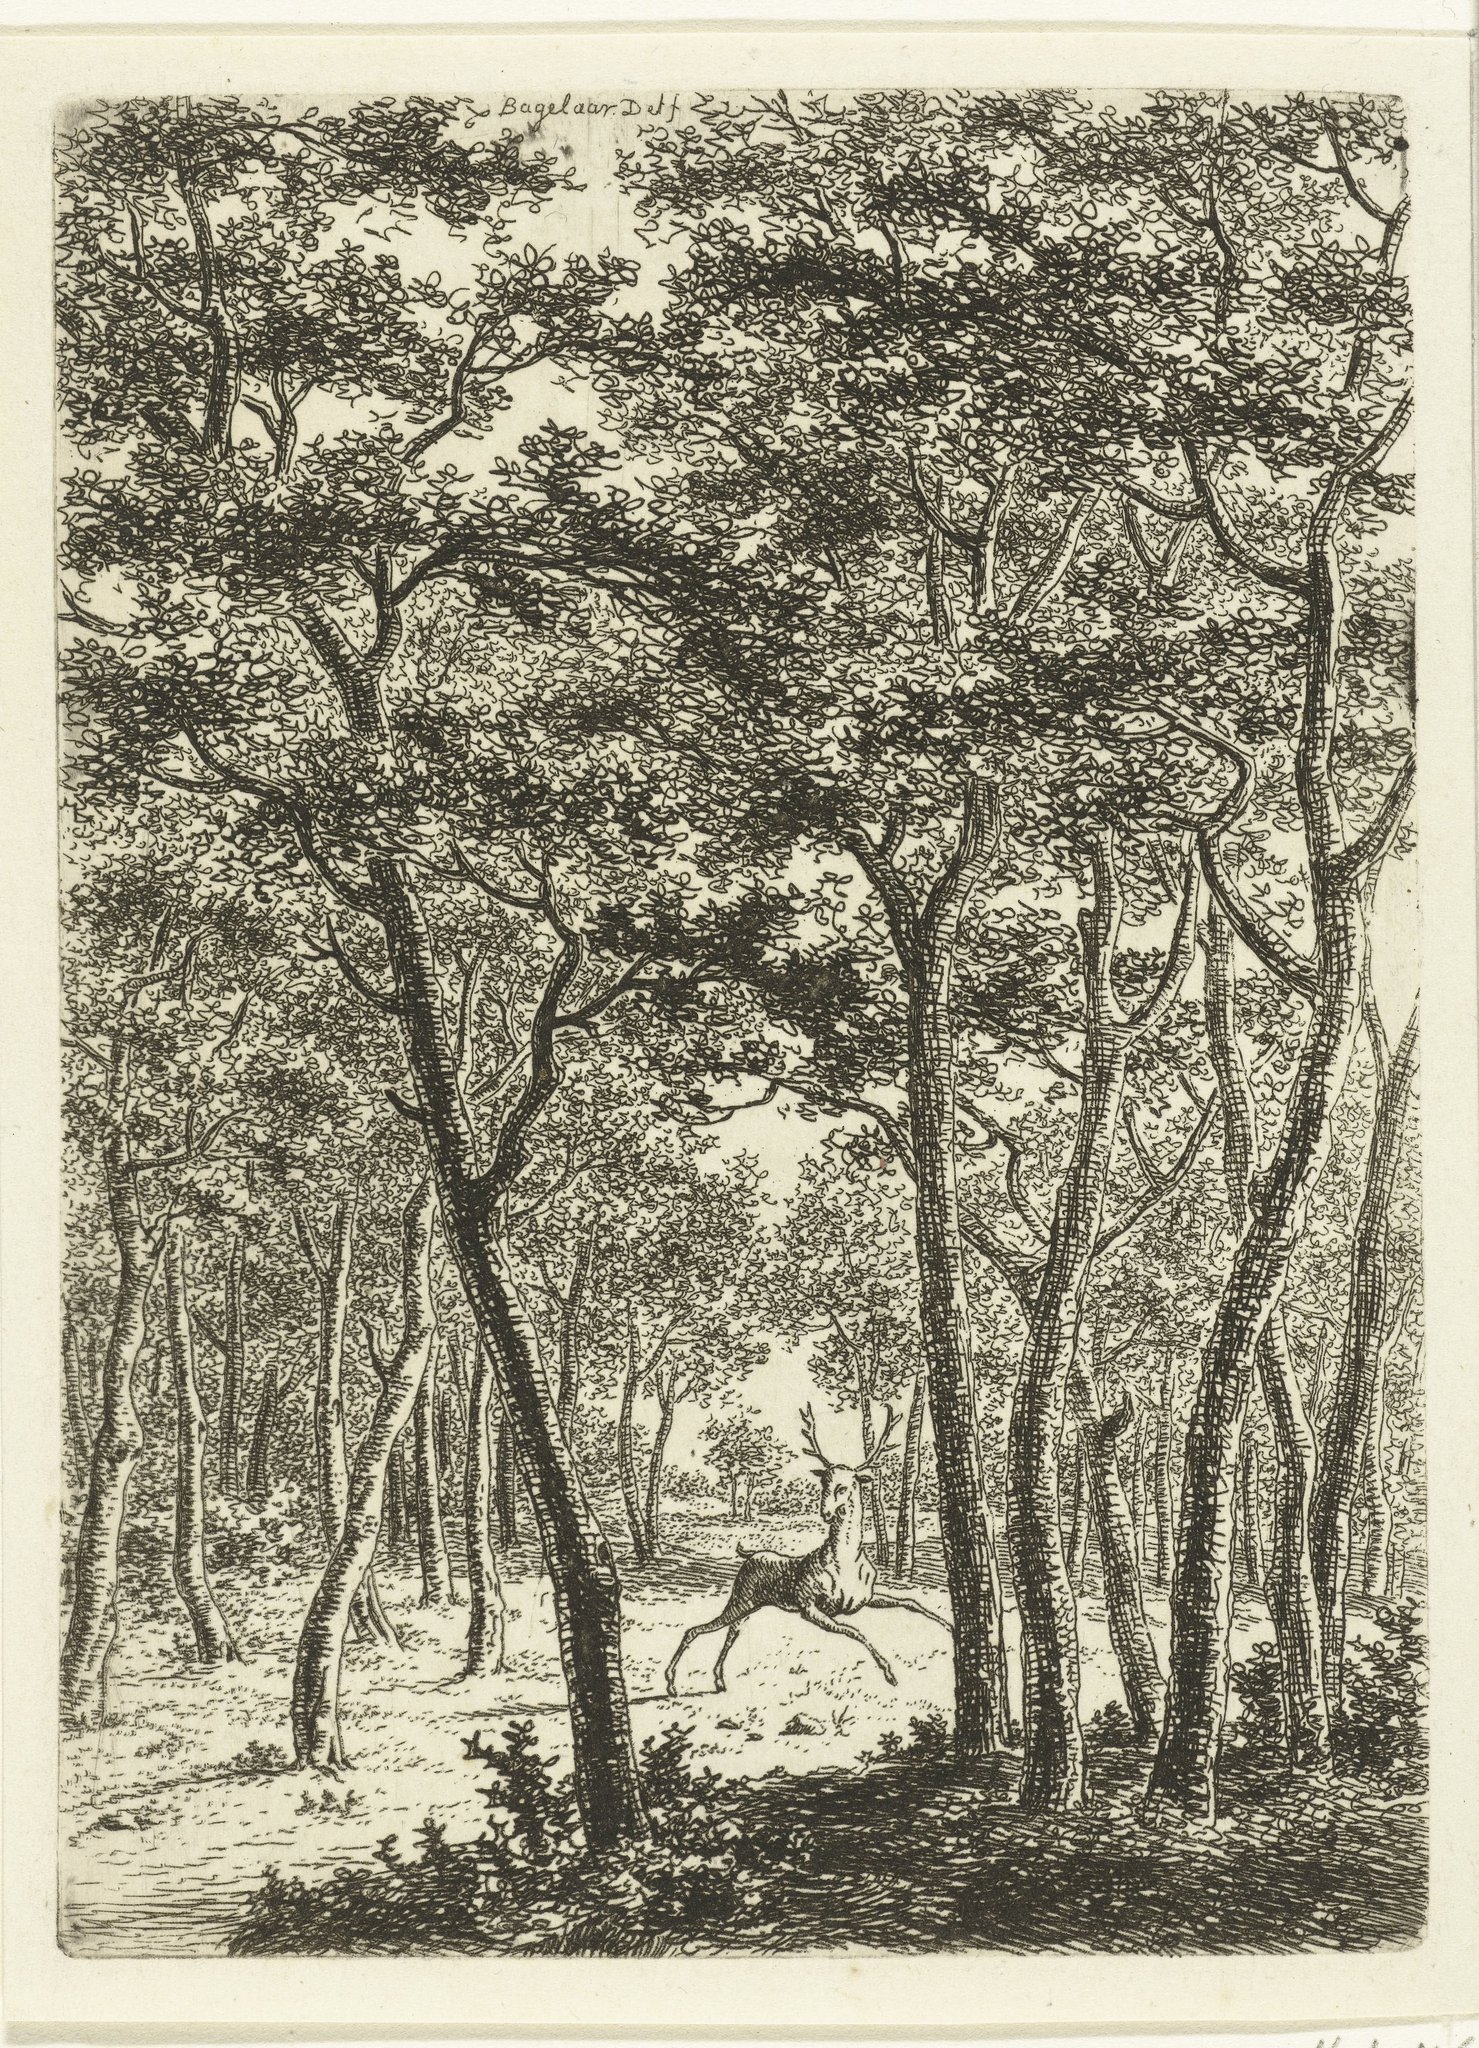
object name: print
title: Boslandschap met hert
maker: ernst willem jan bagelaar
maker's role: draughtsman, print maker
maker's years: 1775-1837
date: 1798-1837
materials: paper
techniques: etching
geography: netherlands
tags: hoofed animals: stag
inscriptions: collector's mark: Lugt 2228